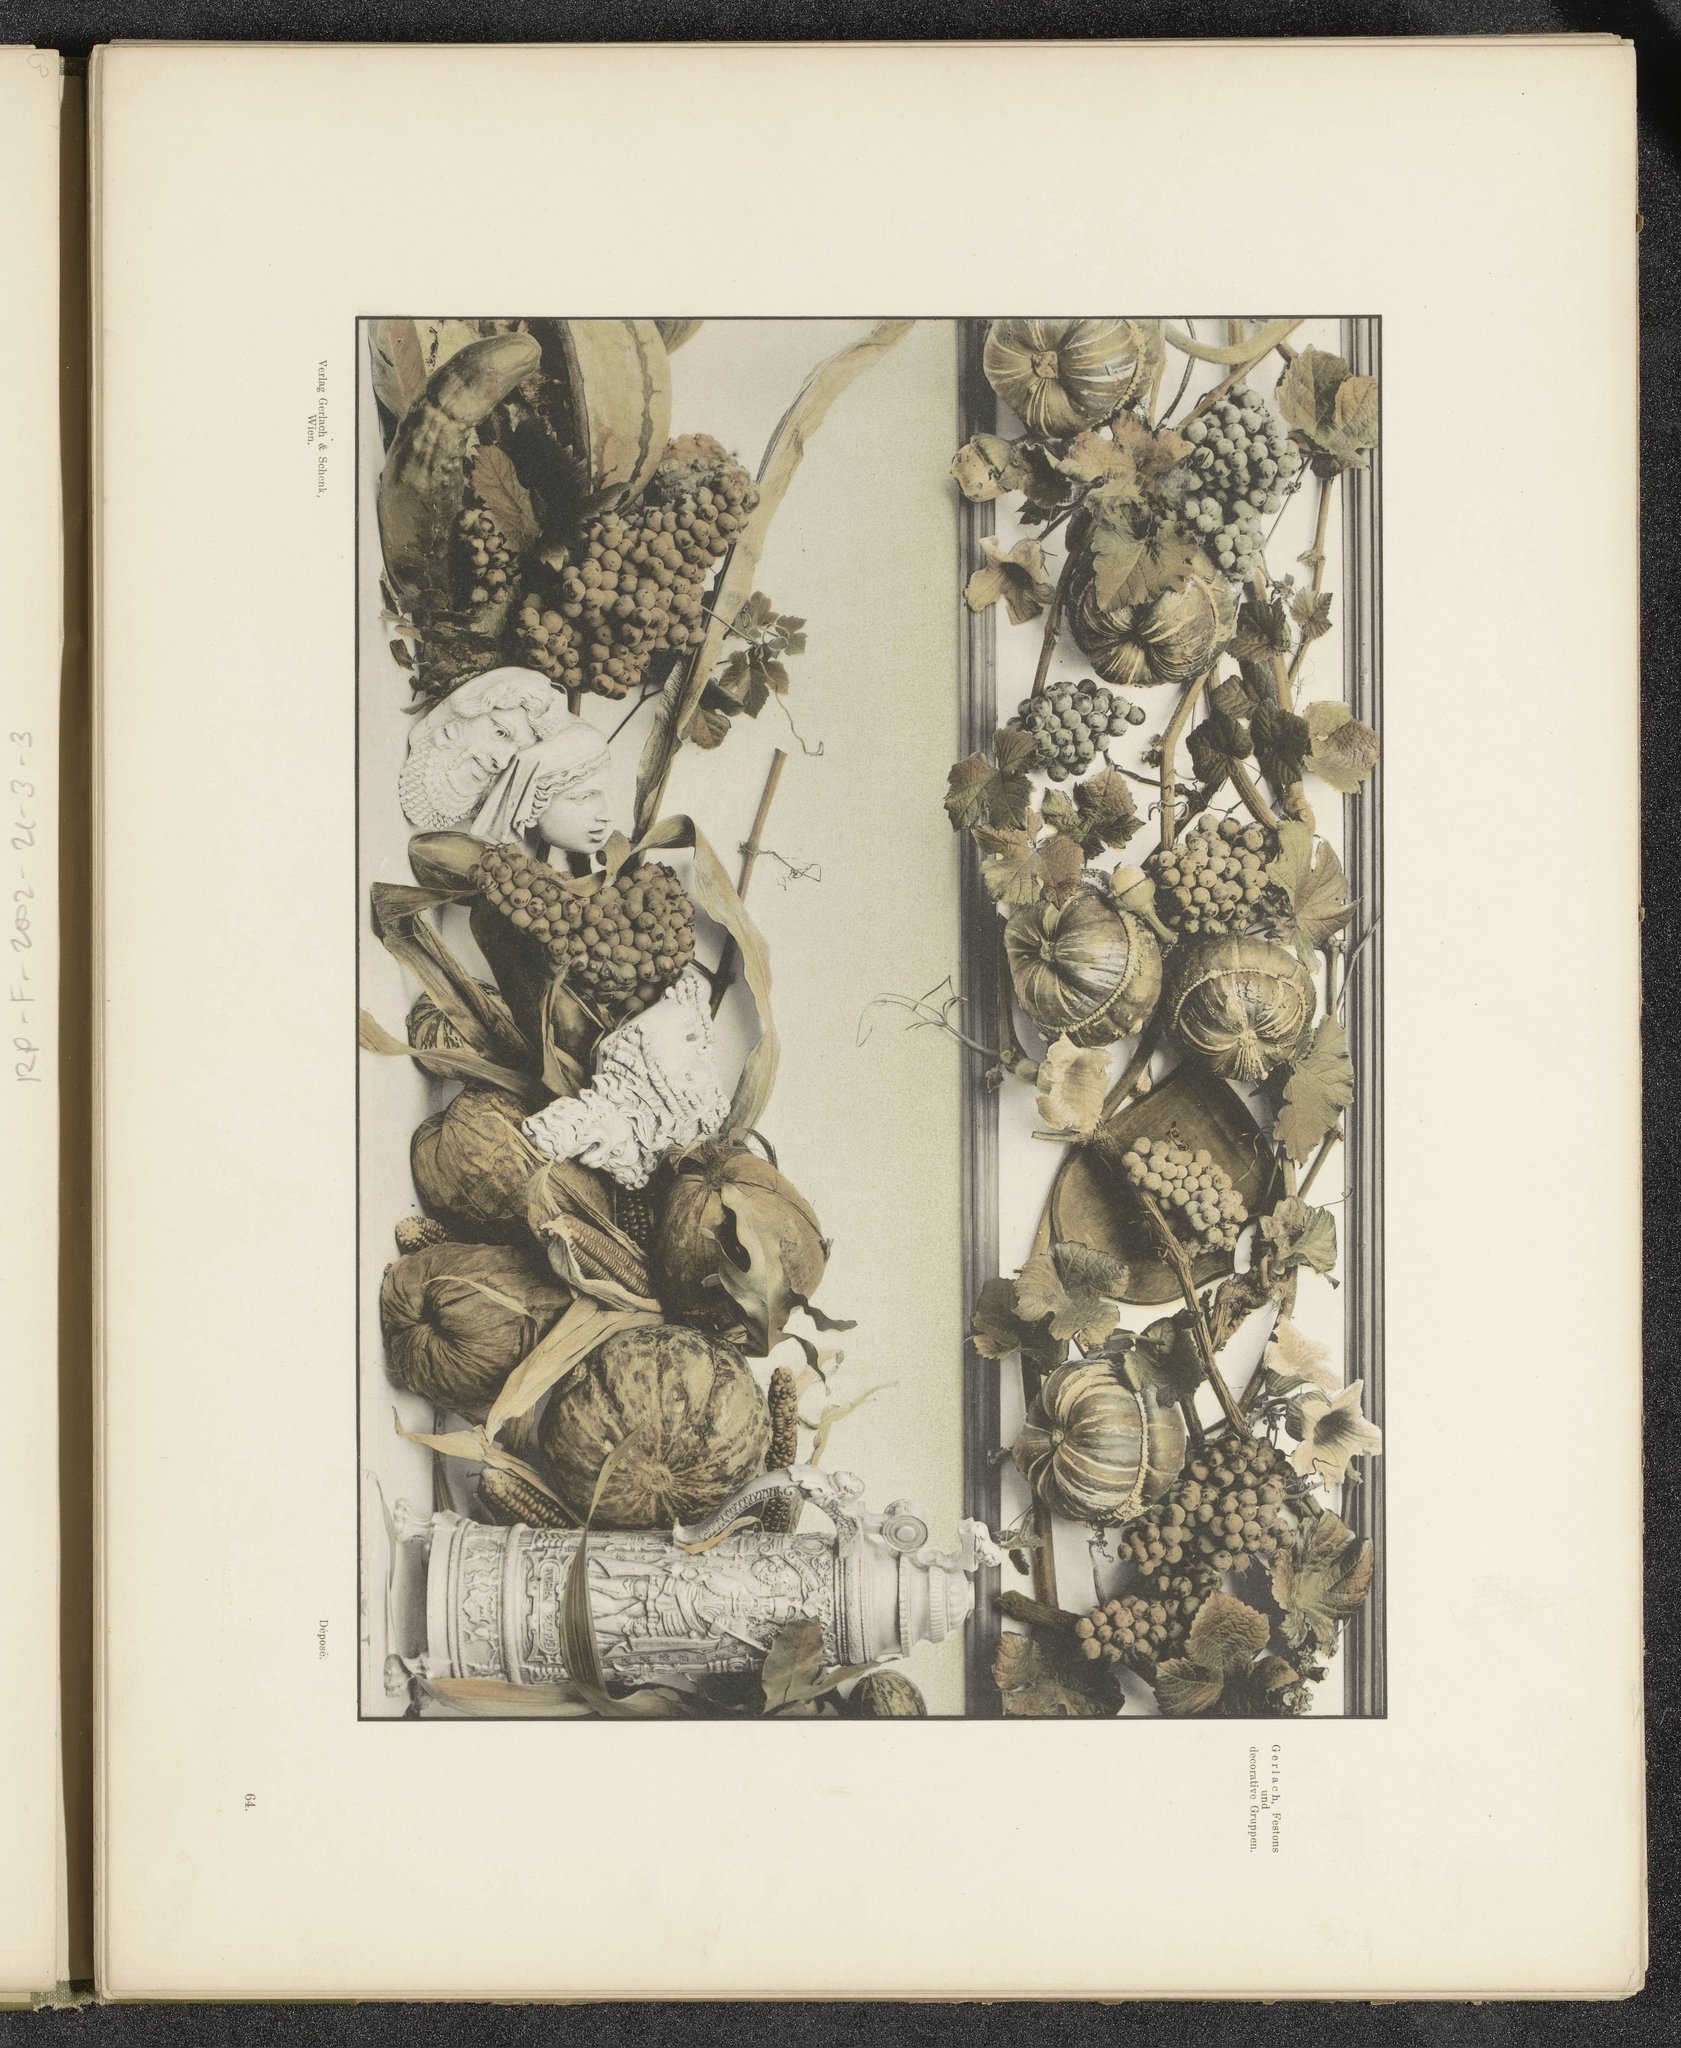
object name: page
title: Decoratieve groep met druiventrossen, pompoenen en maskers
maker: Anonymous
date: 1887-1897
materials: paper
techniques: photograph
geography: vienna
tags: mask, mascaron ~ ornament, fruits: pumpkin, bunch of grapes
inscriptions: number: ‘64.’